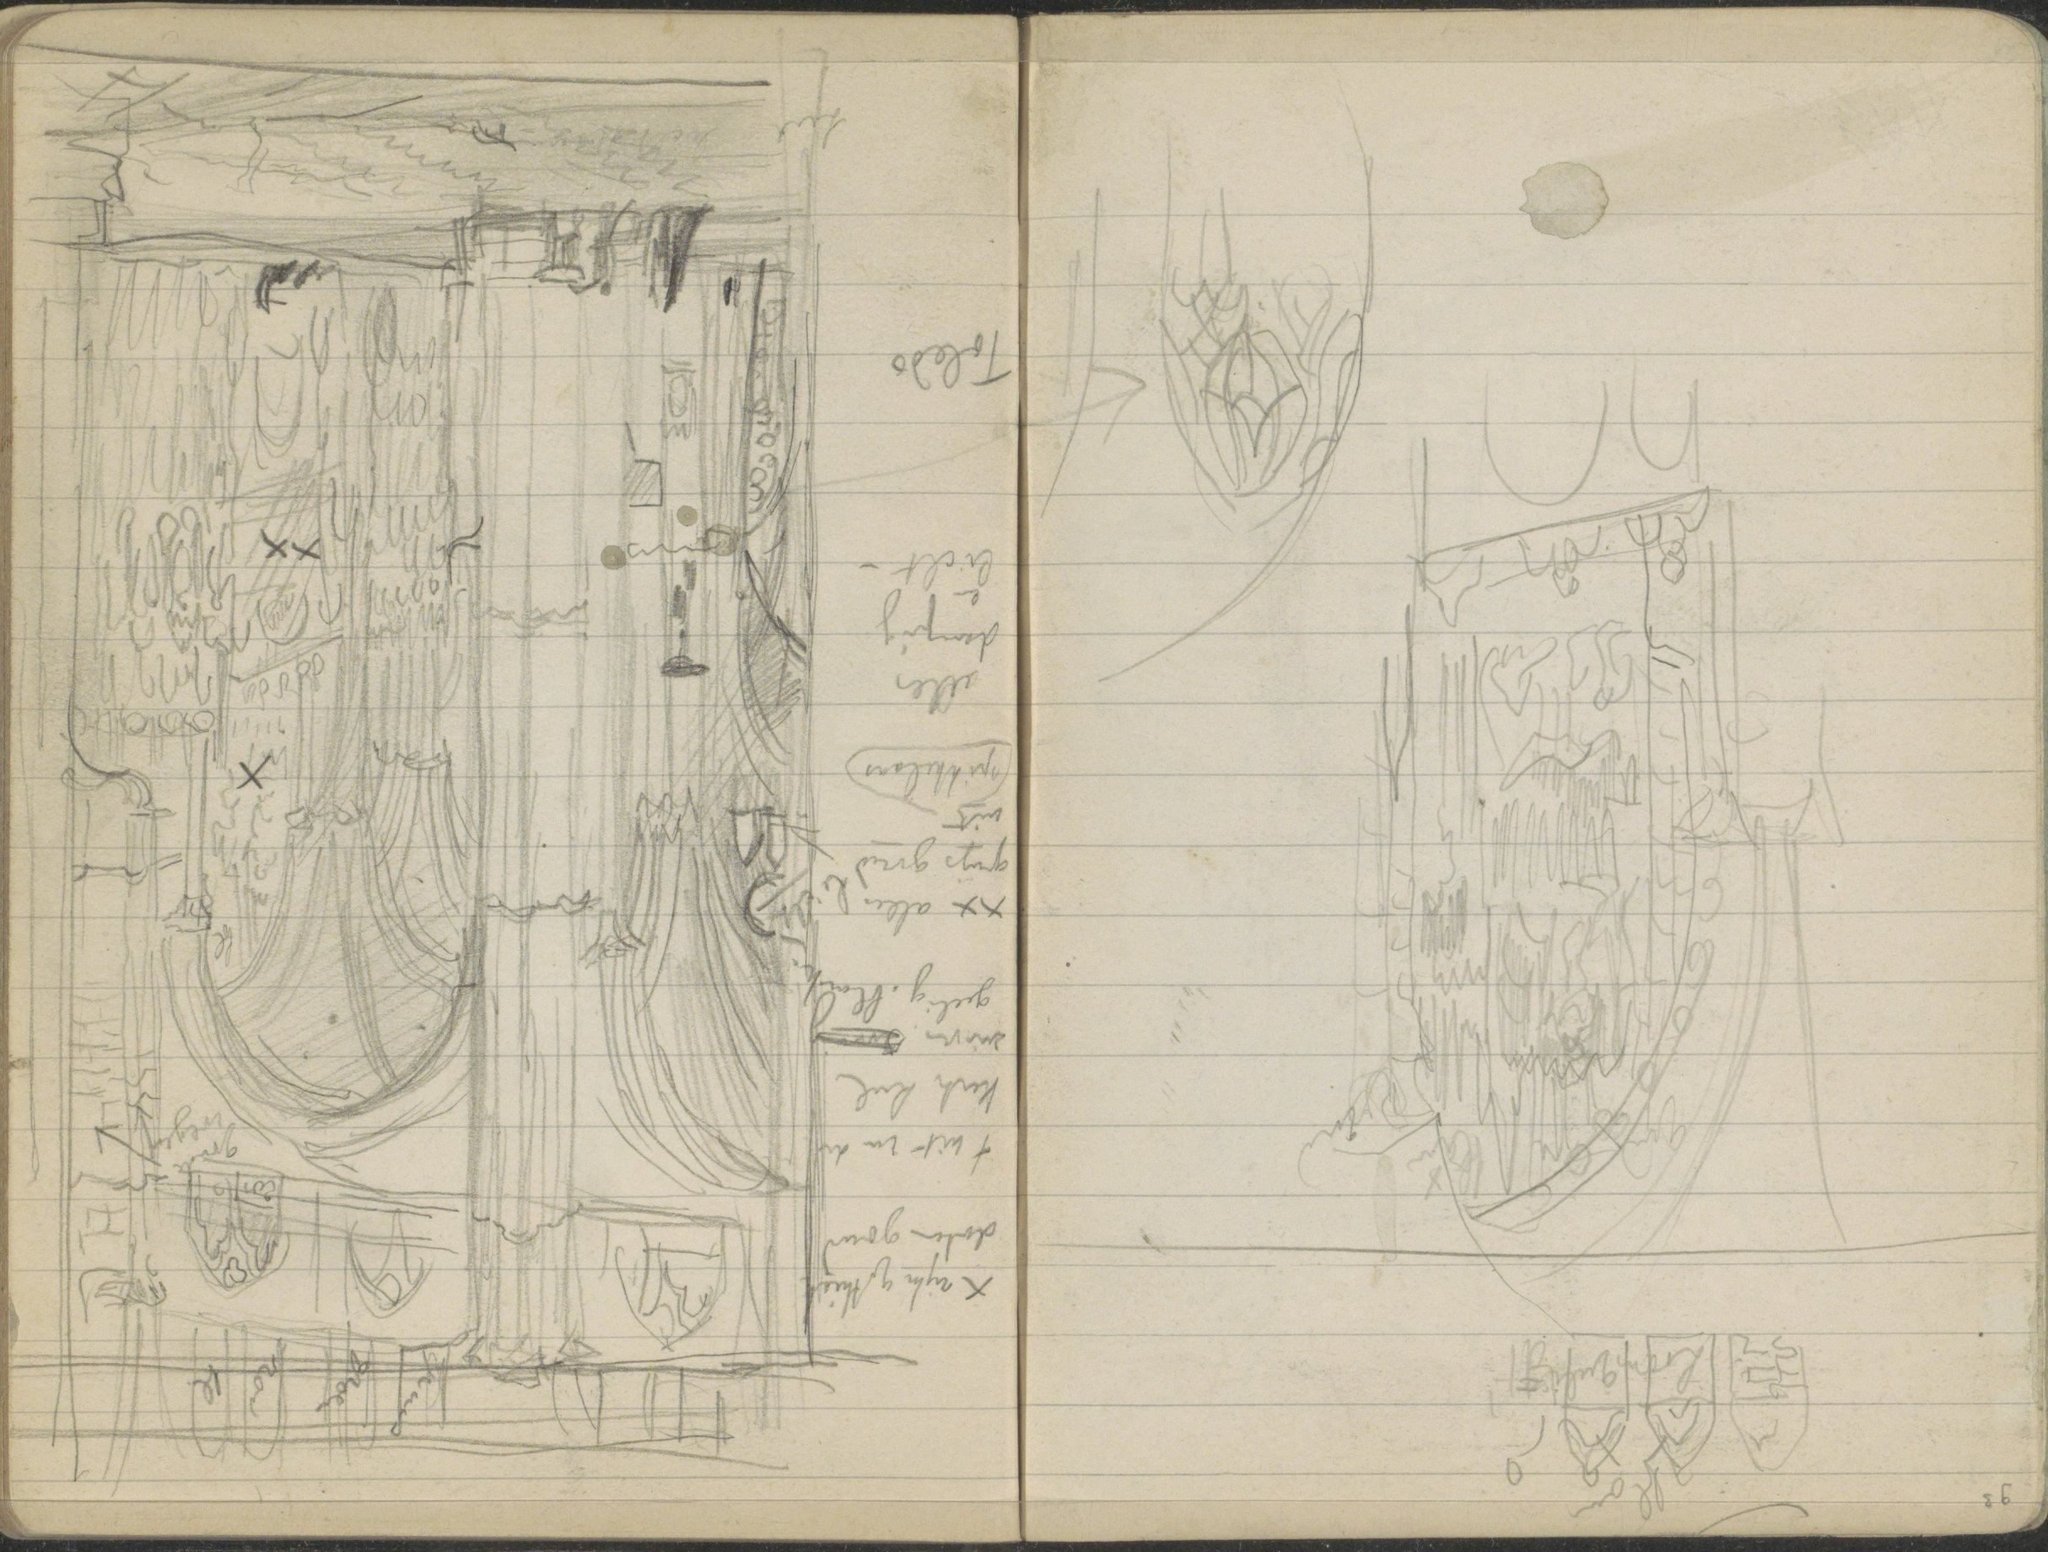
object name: sketchbook leaf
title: Interieur van de kathedraal van Toledo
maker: marius bauer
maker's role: draughtsman, print maker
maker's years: 1867-1932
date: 1902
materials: pencil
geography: toledo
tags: interior of church, toledo cathedral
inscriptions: annotation: ‘Toledo’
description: Pagina 92 uit een schetsboek met 50 bladen.